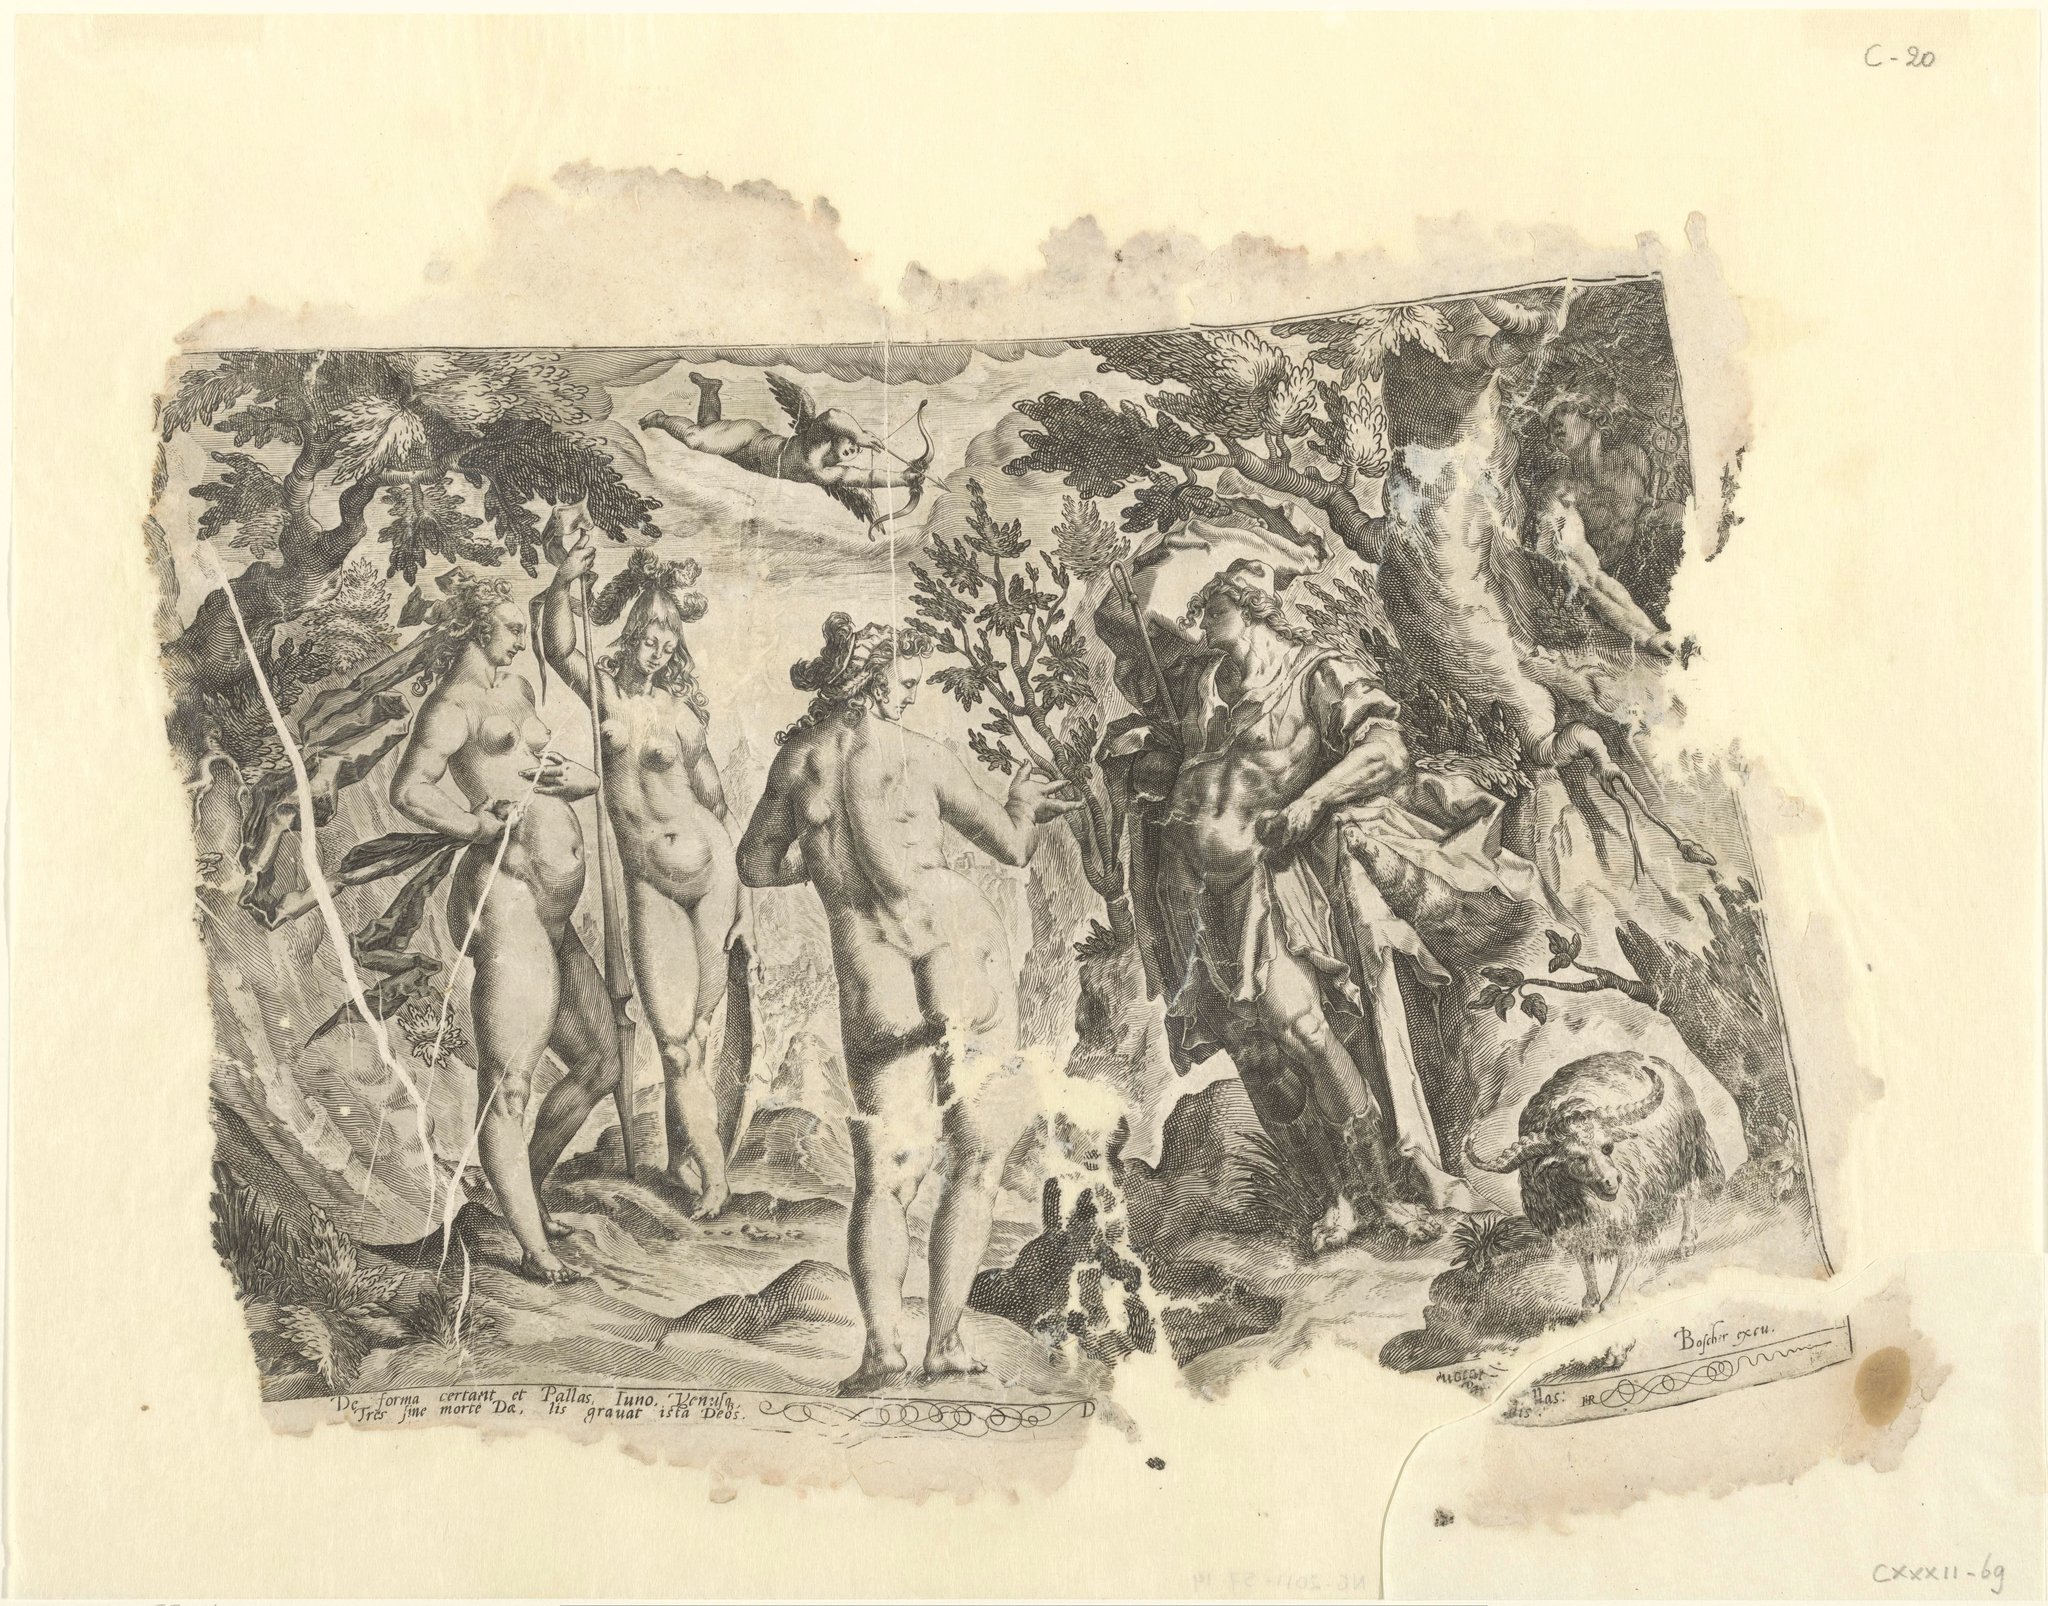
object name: print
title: Oordeel van Paris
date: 1580-1596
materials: paper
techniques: engraving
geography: amsterdam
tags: the judgement of paris (mercury present)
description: De prenten in de Nova Zembla collectie zijn tijdens een expeditie van Willem Barendsz en Jacob van Heemskerk in 1596-1597 noodgedwongen in het winterkamp, het ‘Behouden Huis’, op het eiland achtergelaten. De prenten waren in één of meerdere stapels als handelswaar meegenomen vanuit Amsterdam. Bijna drie eeuwen later, in 1871, keerde de Noor Elling Carlsen terug naar Nova Zembla en vond daar de restanten van het ‘Behouden Huis, inclusief een groot deel van de inventaris. Een deel van de prenten, in de vorm van aaneengekoekte kluiten, werd toen ook teruggevonden. De papierkluiten waren soms op meerdere plekken gebroken. Tussen 1975-1979 zijn de prenten van elkaar gescheiden. Dit leverde in totaal ca. 1000 fragmenten van ca. 400 afdrukken van ca. 150 verschillende prenten op. Voor zover mogelijk zijn de fragmenten samengevoegd en zijn de prenten gereconstrueerd.